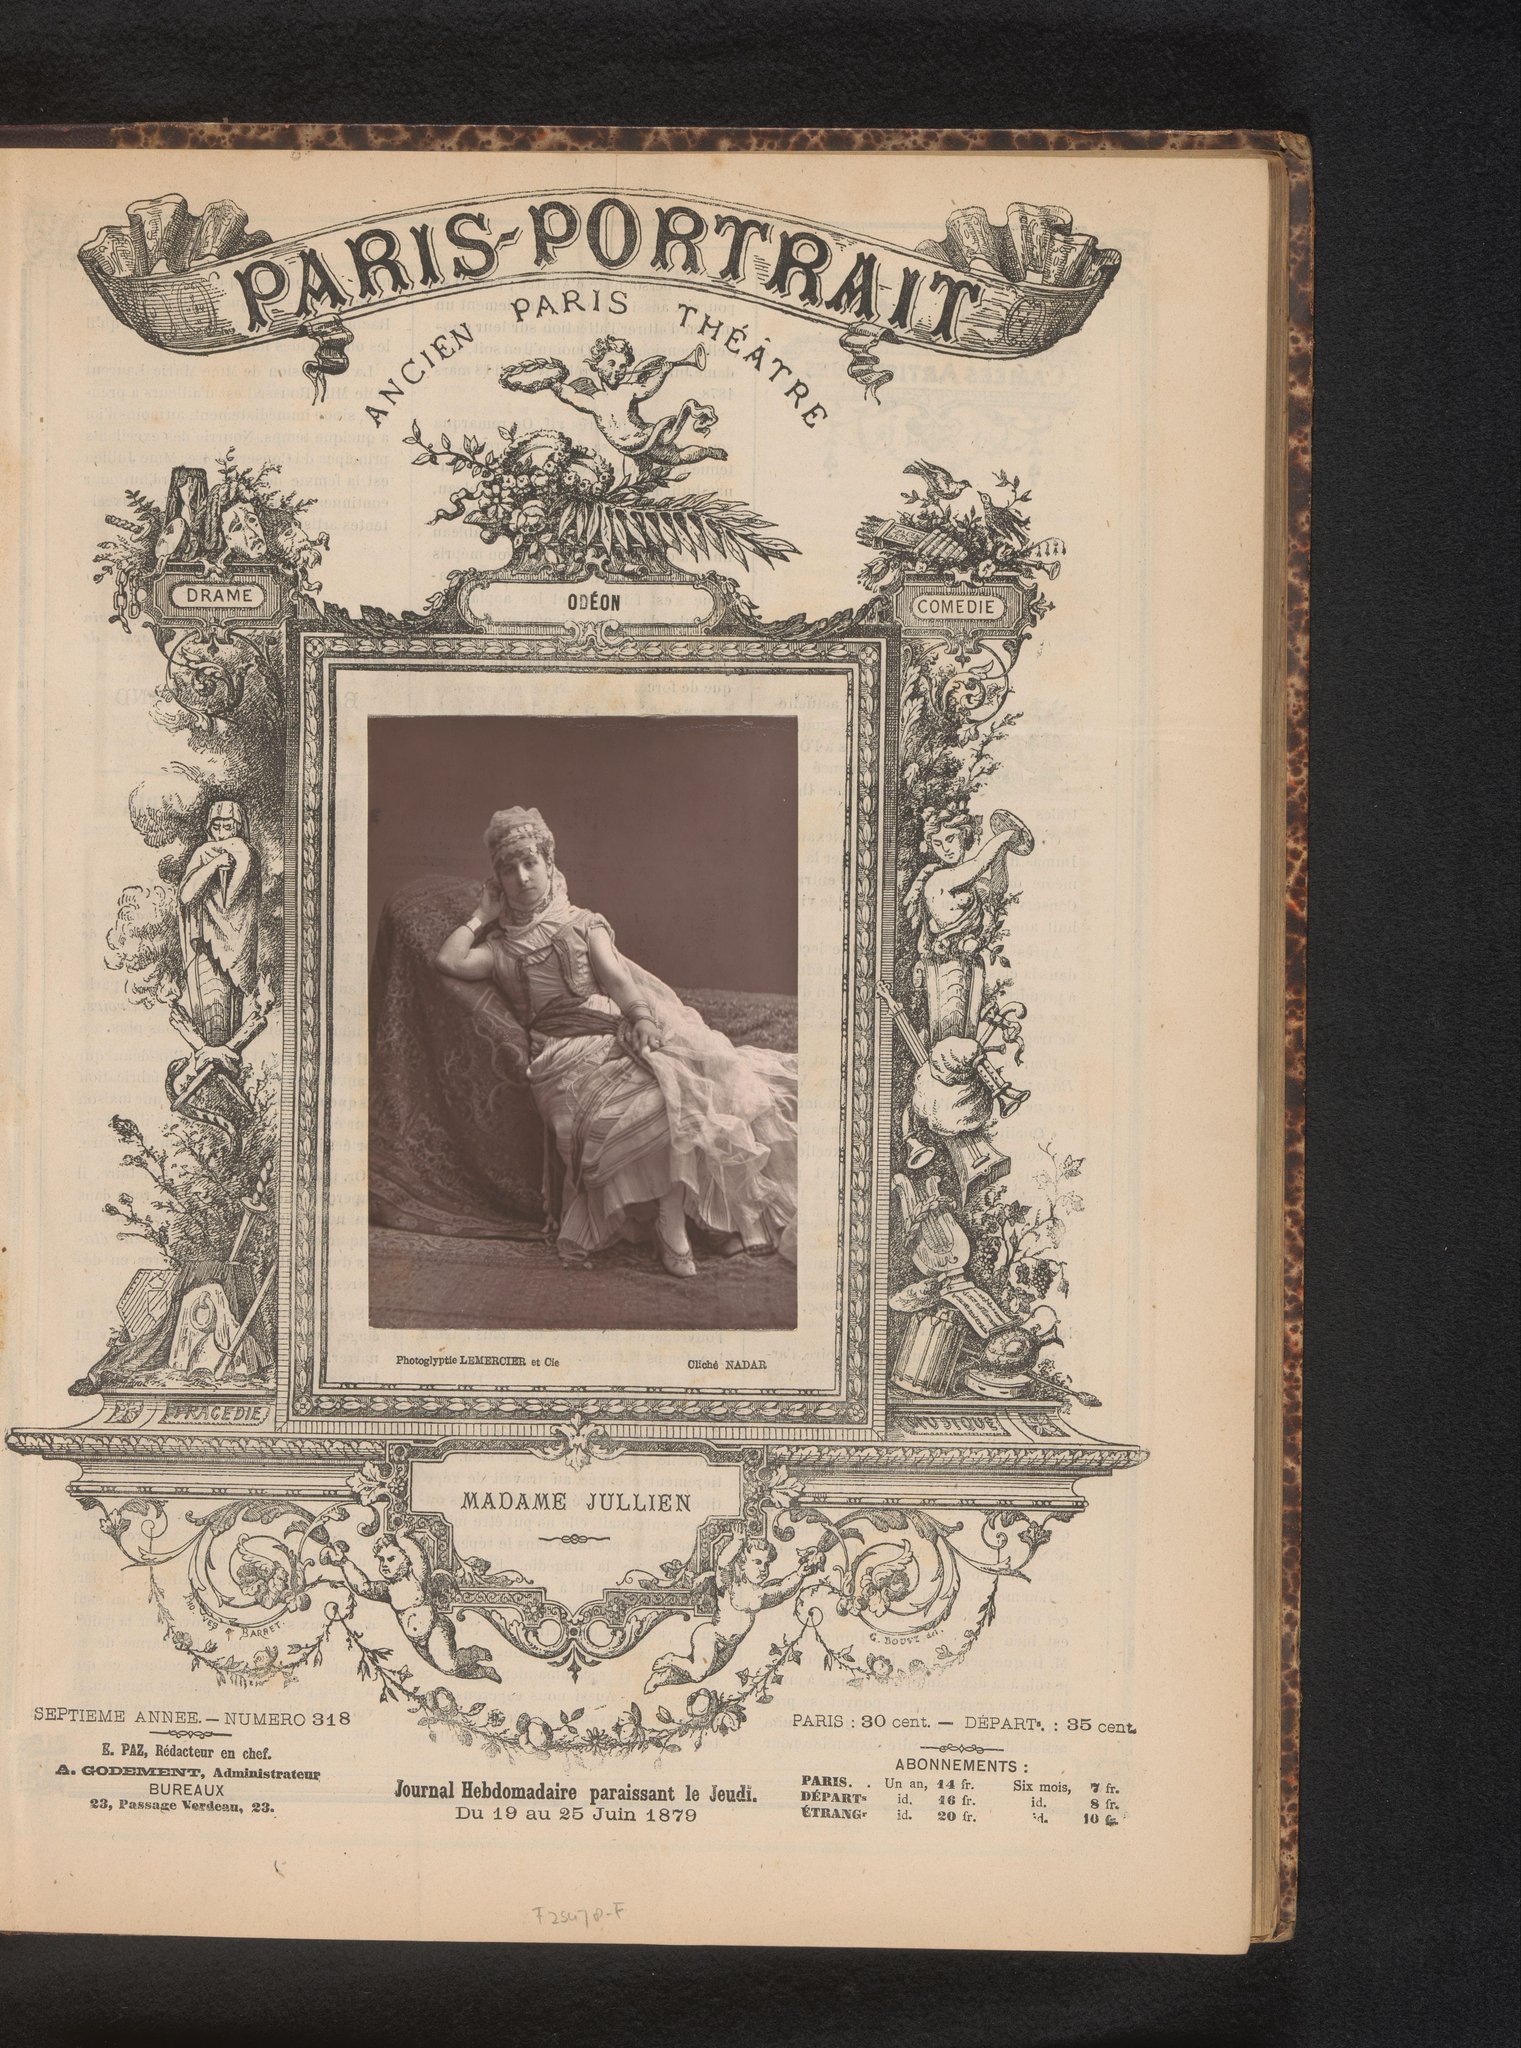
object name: photomechanical print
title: Portret van mevrouw Jullien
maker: félix nadar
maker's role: ballonvaarder, fotograaf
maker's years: 1820-1910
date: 1873-1880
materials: paper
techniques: woodburytype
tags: historical persons - bb - woman